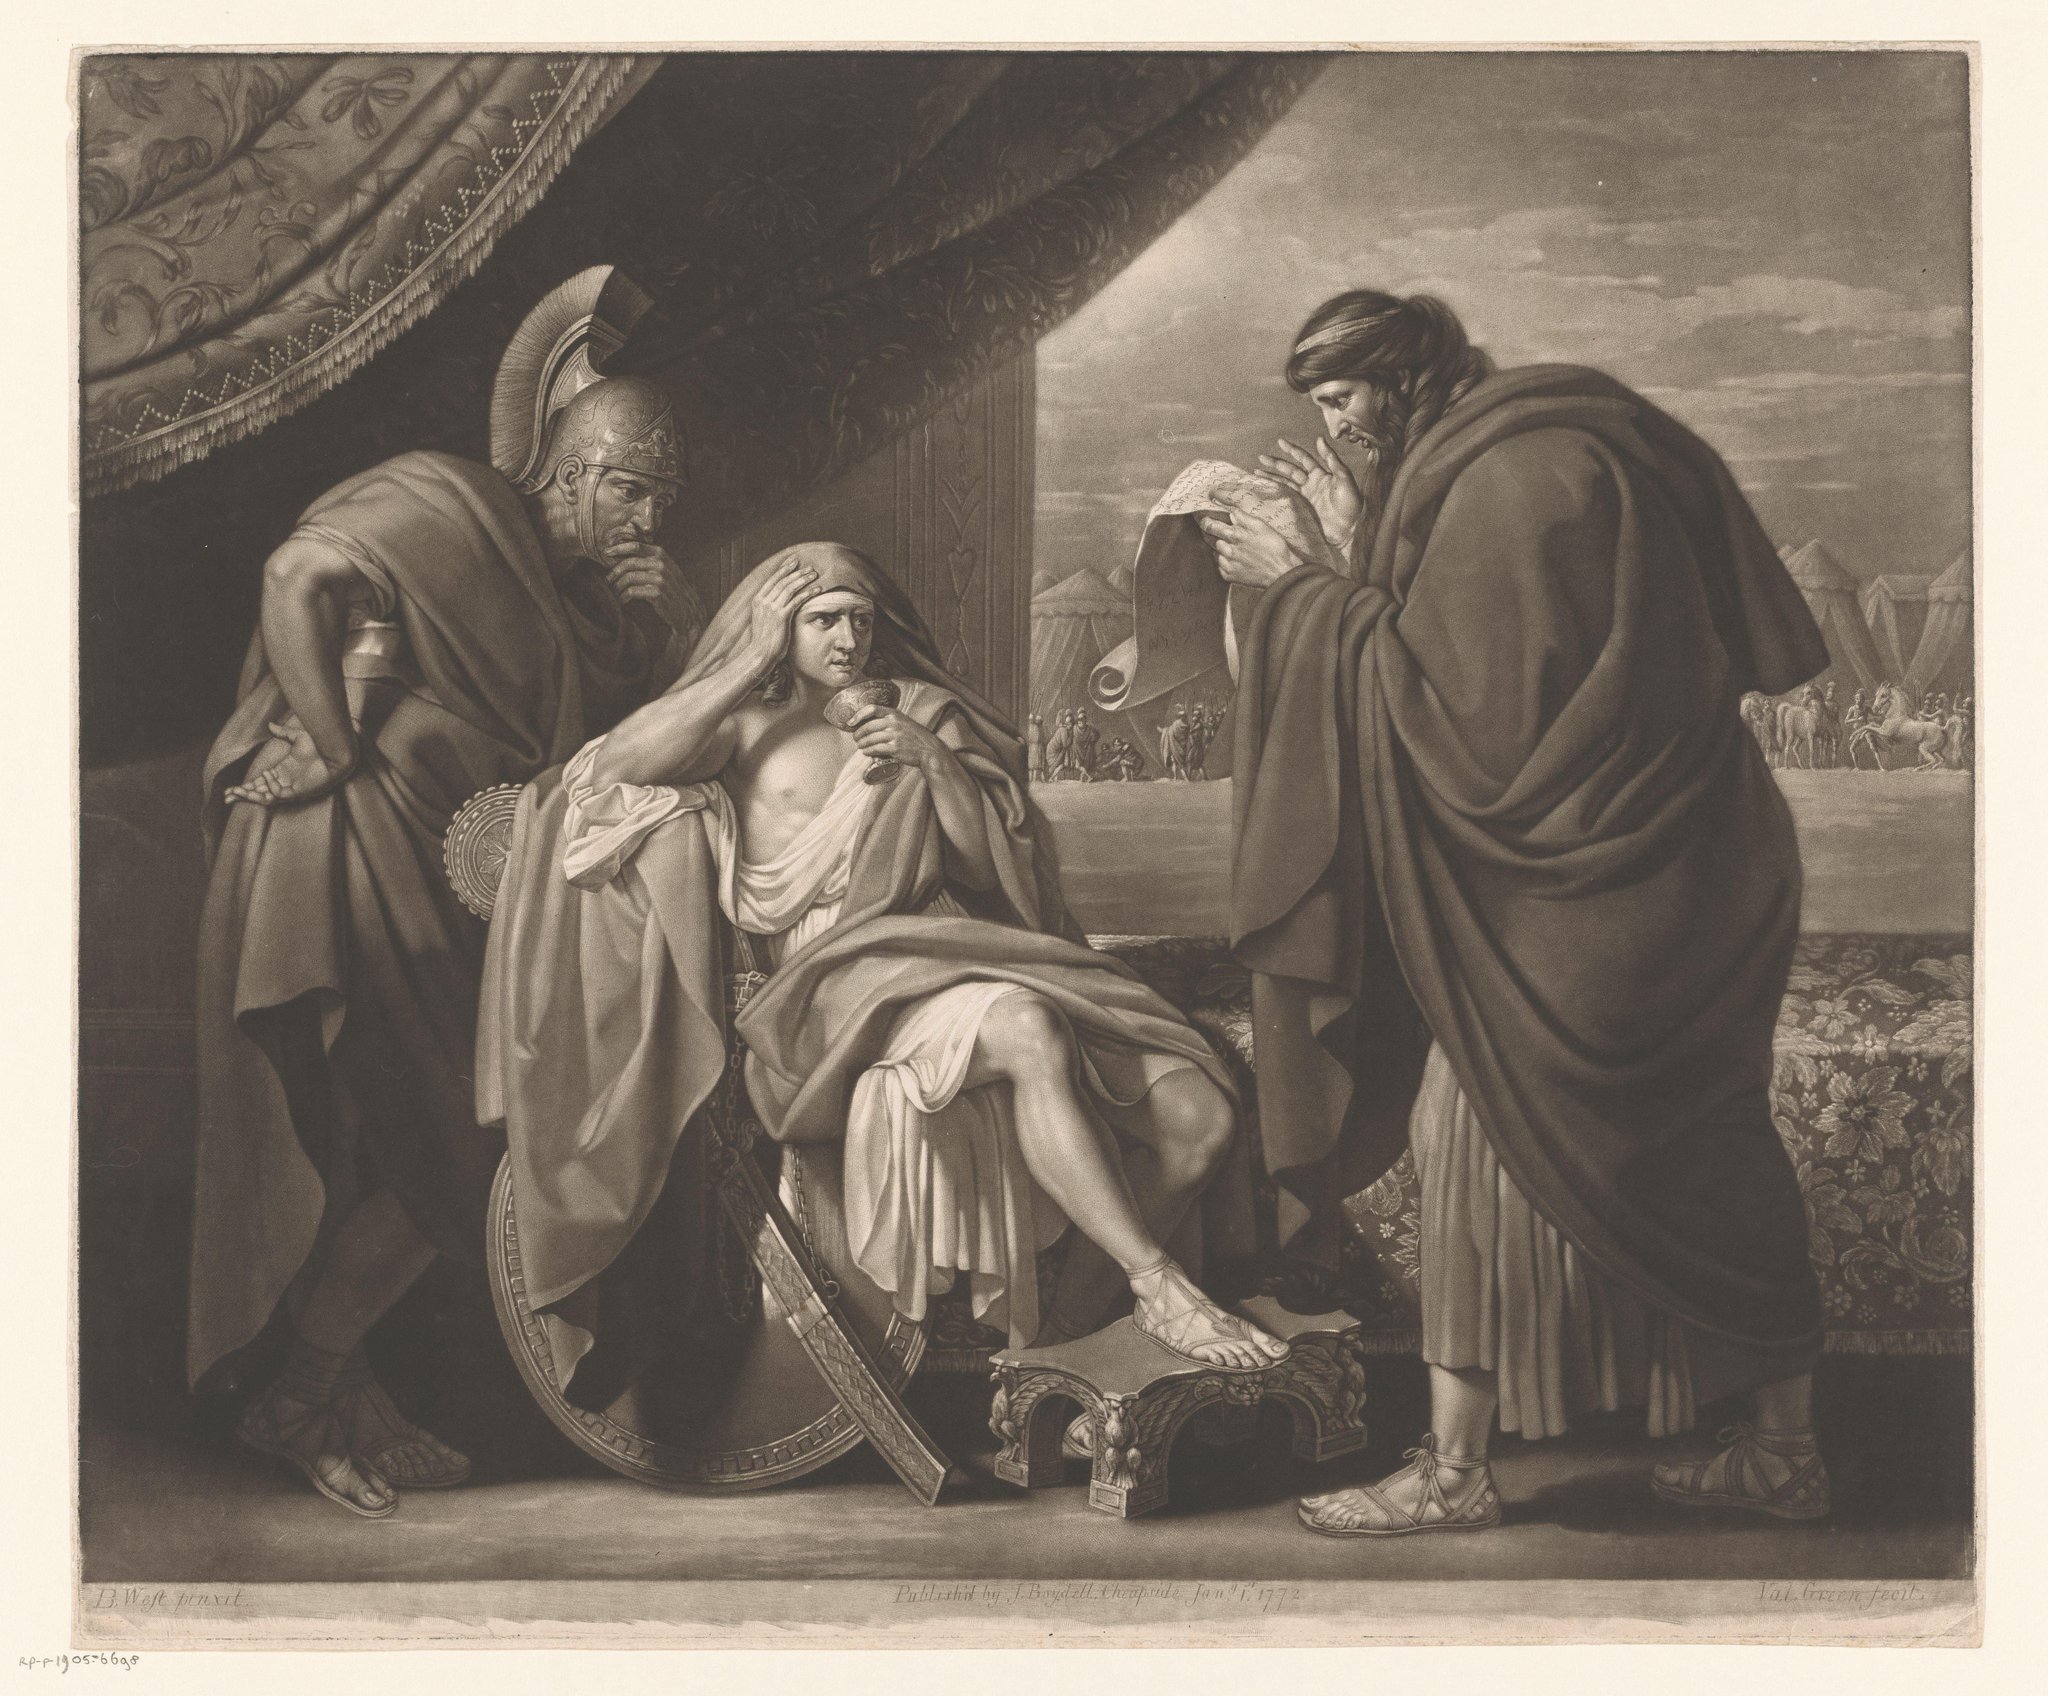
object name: print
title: Philippus van Acarnanië leest een brief voor aan Alexander de Grote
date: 1701-1772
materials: paper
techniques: etching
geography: london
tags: scroll - ll - scroll unfolded, (military) camp with tents, historical persons, reading to somebody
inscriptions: collector's mark: Lugt 2228